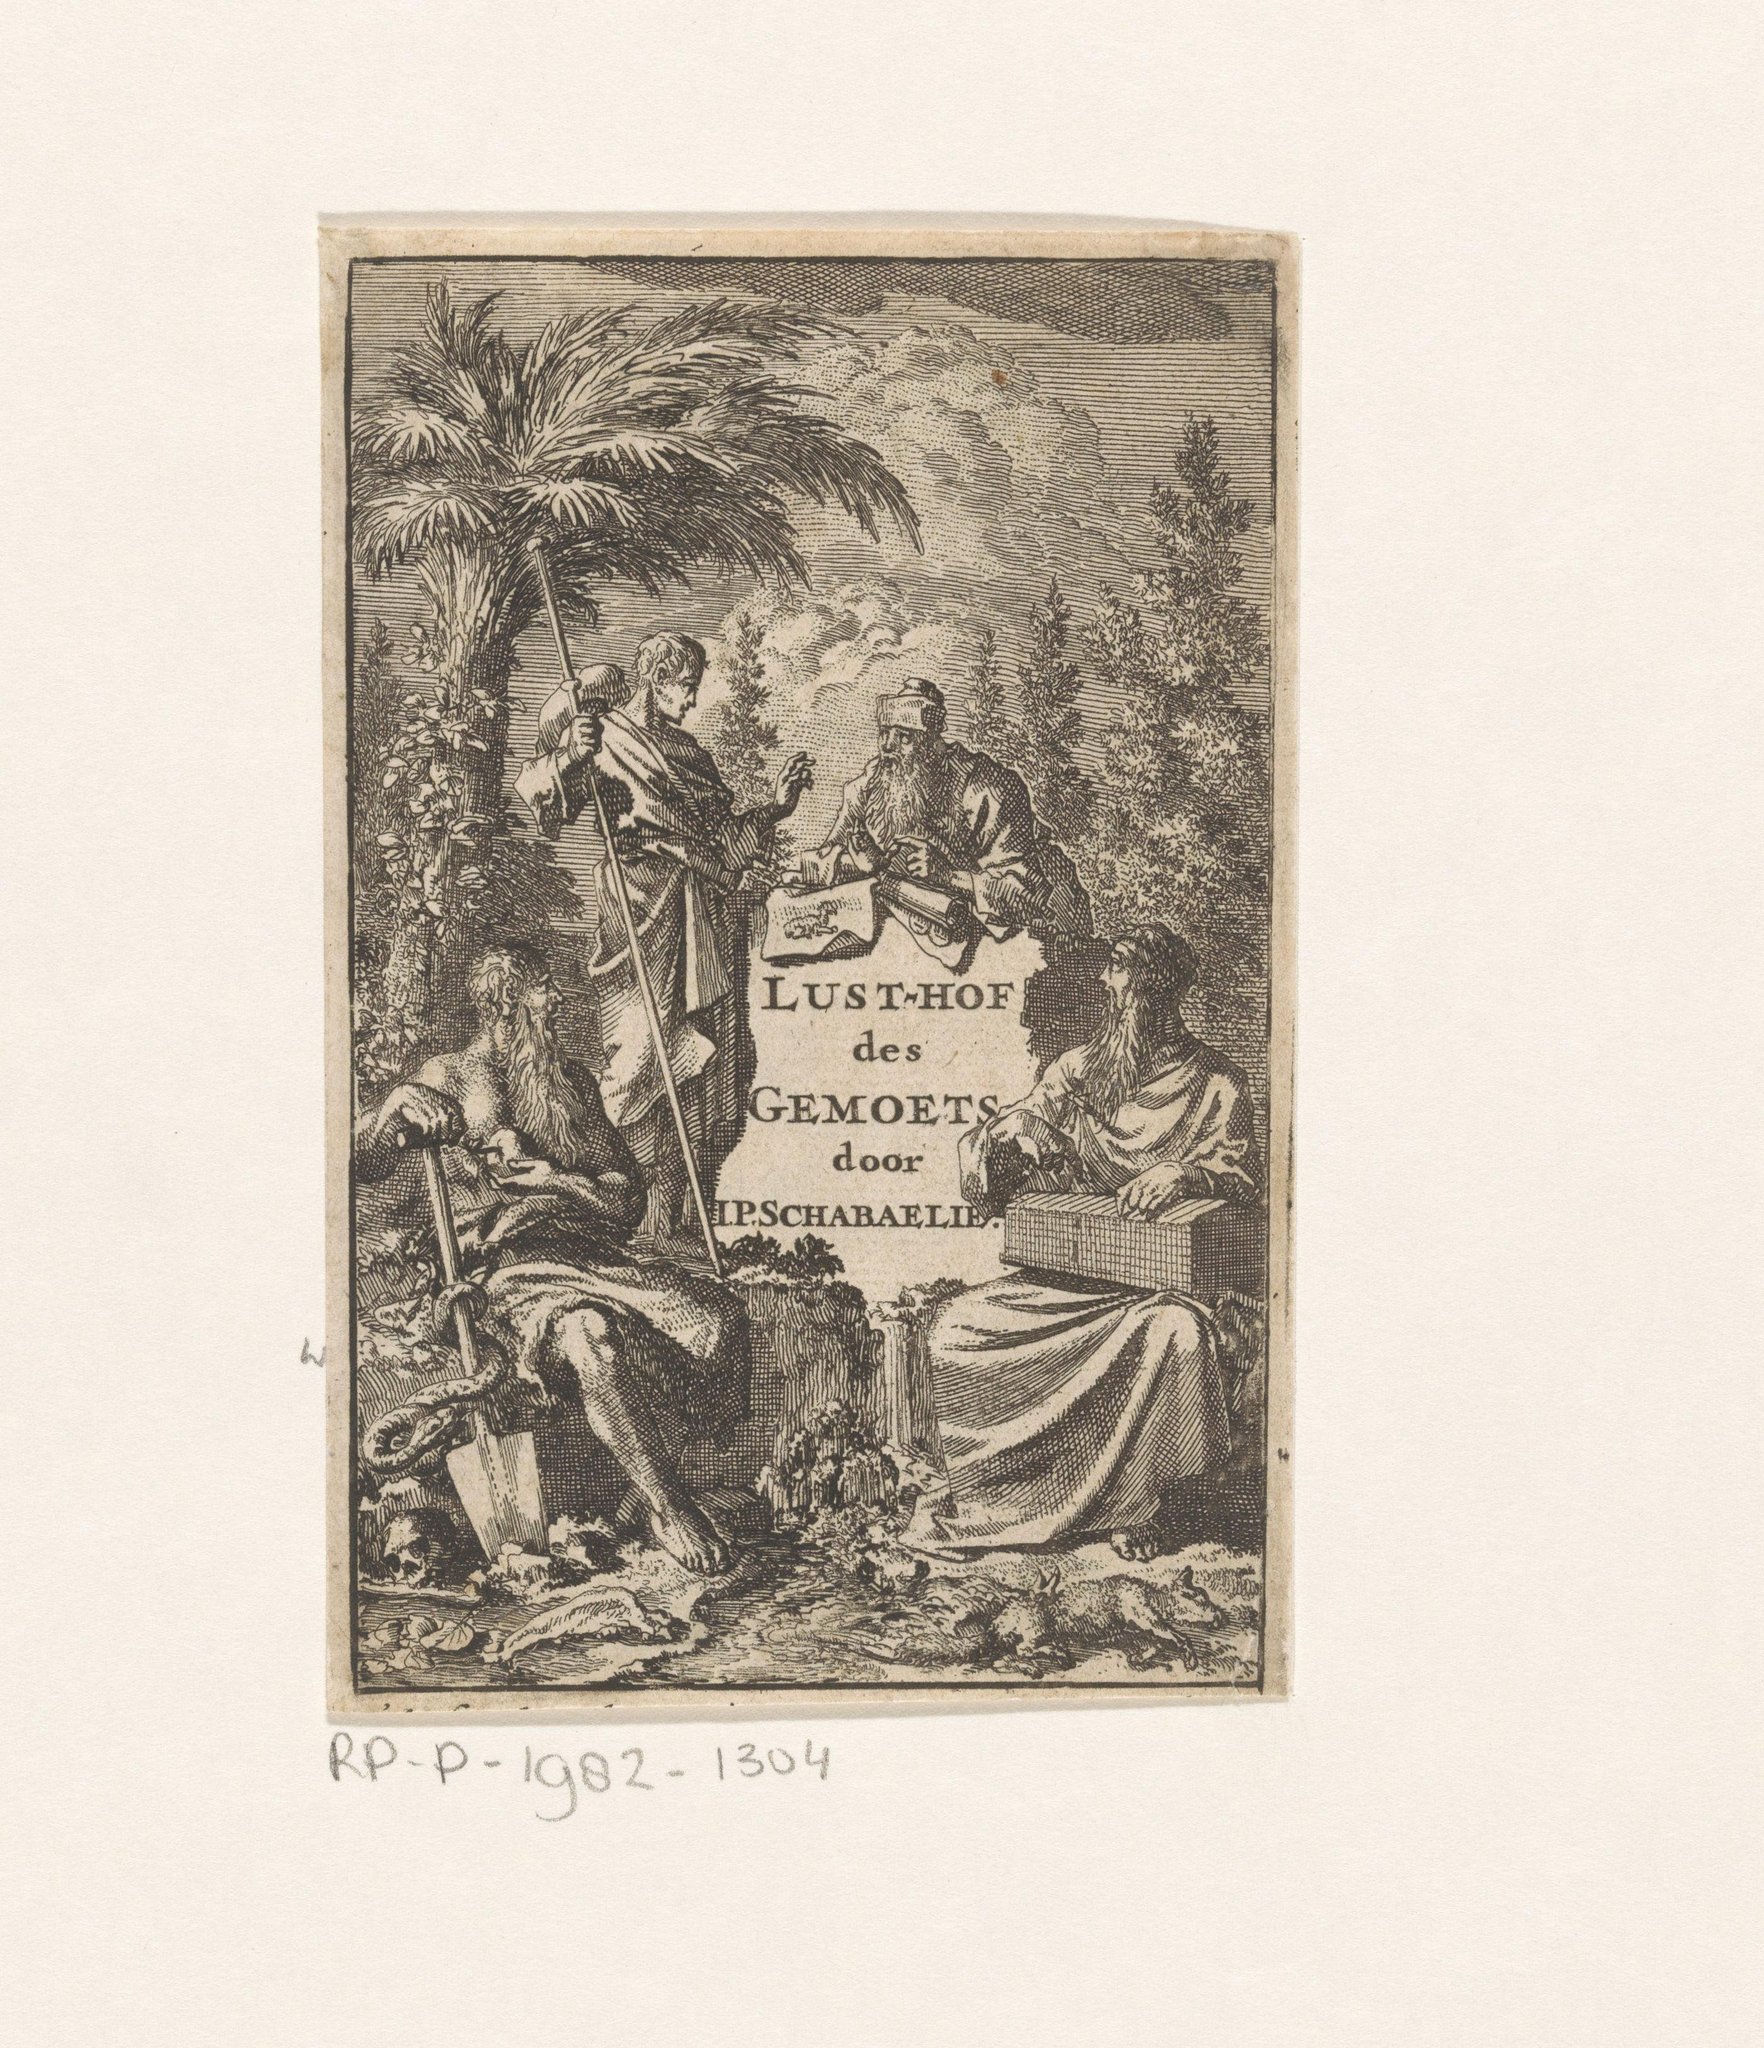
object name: titelblad, titelpagina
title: Lust-hof des Gemoets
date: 1706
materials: paper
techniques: etching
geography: amsterdam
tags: adam (not in biblical context)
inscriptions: collector's mark: Lugt 2228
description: Adam met slang, appel en schedel en Noach met een model van de ark zitten aan weerszijden van een cartouche met de titel van het boek. Achter hen zijn twee figuren in gesprek.